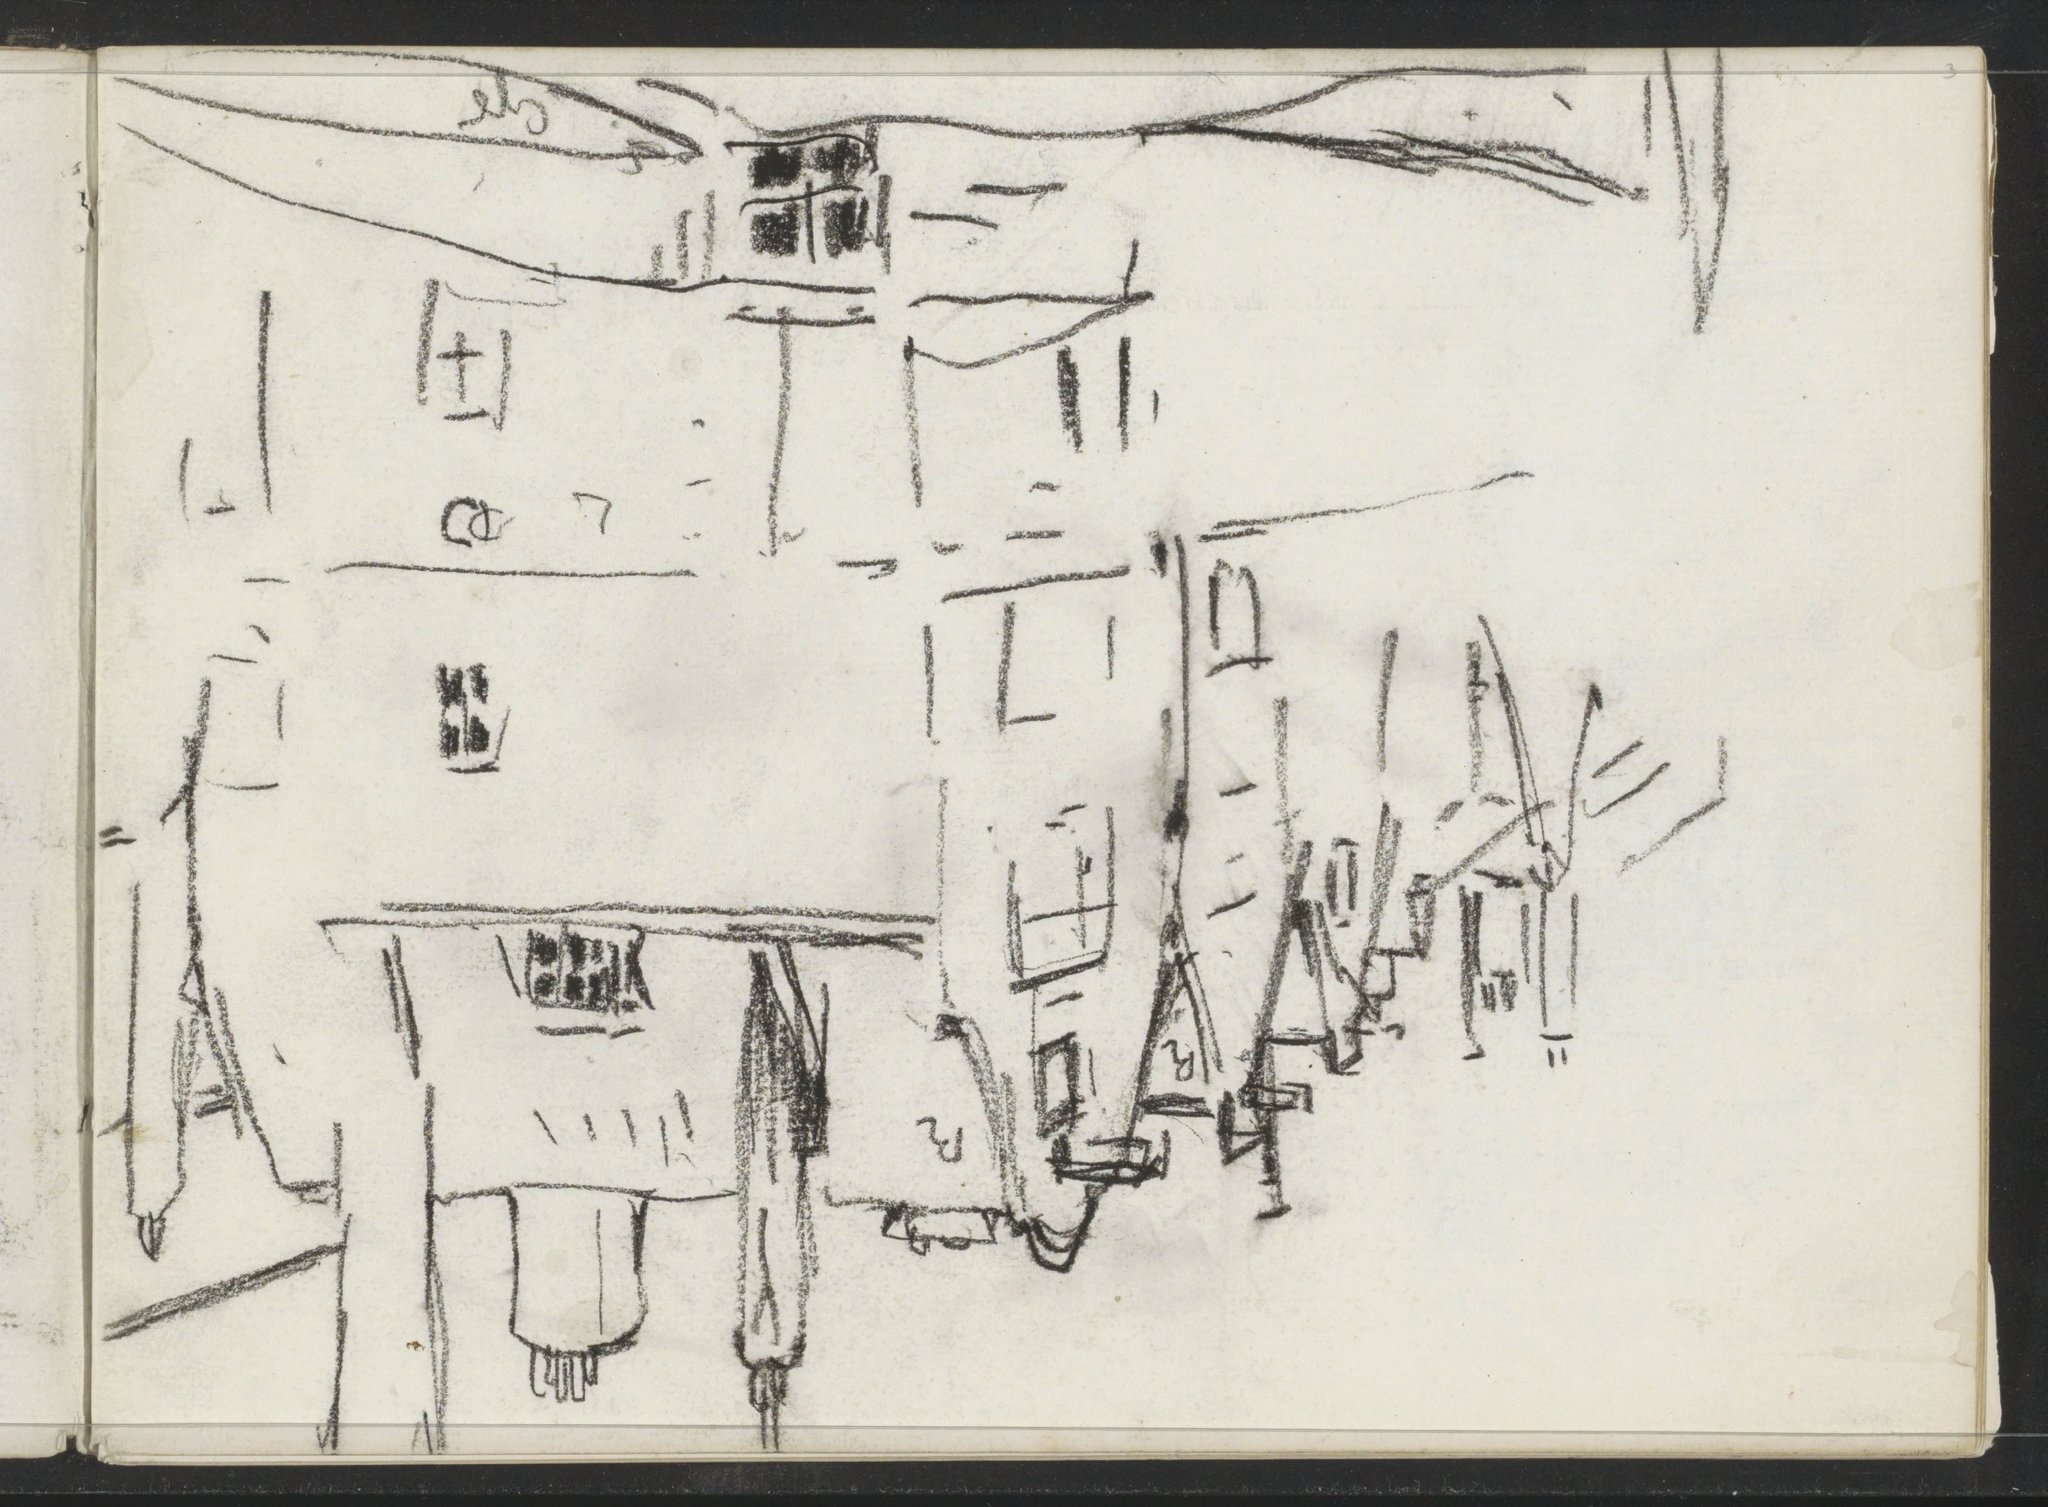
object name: sketchbook leaf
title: Gezicht op de hoek van de Korte Dijkstraat en de Krom Boomssloot te Amsterdam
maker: willem witsen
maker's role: draughtsman, painter, print maker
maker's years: 1860-1923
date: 1897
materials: chalk, paper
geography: amsterdam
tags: urban housing, canals, waters (in city)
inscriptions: kleurnotitie, handgeschreven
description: Pagina 3 uit een schetsboek met 13 bladen.